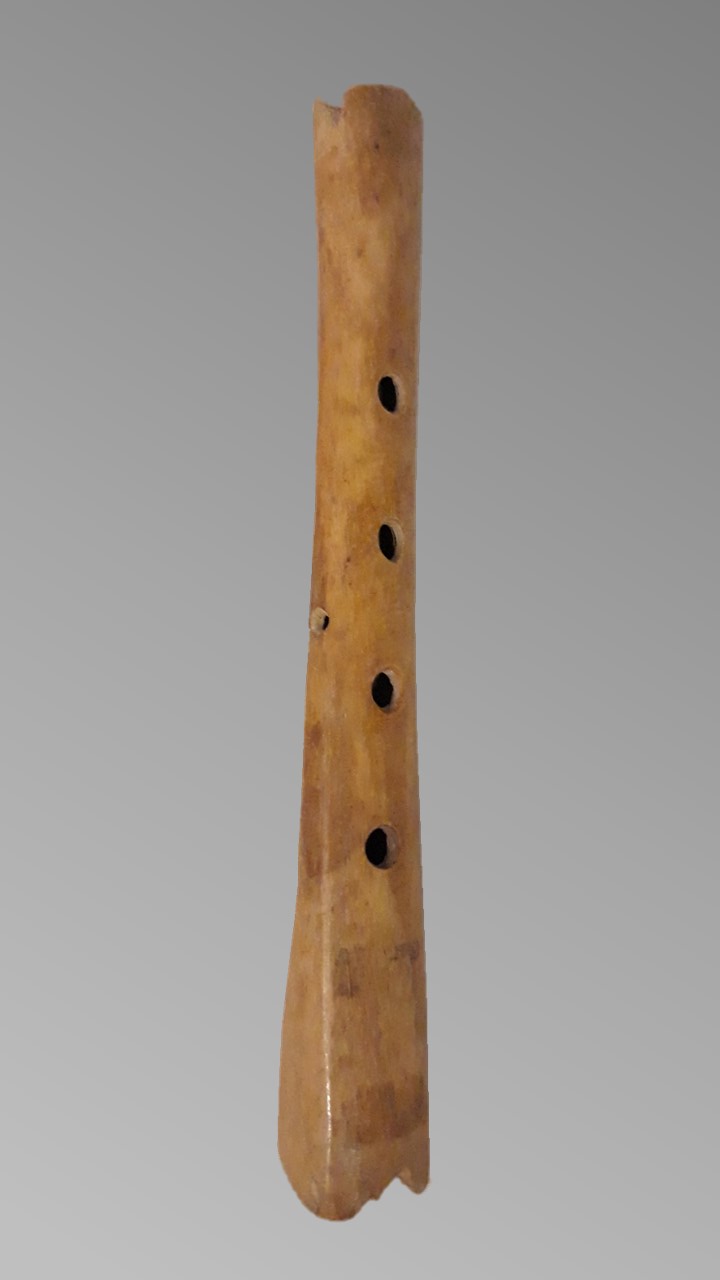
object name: quena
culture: native american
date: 1801-1900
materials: bone, rubber, wax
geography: peru